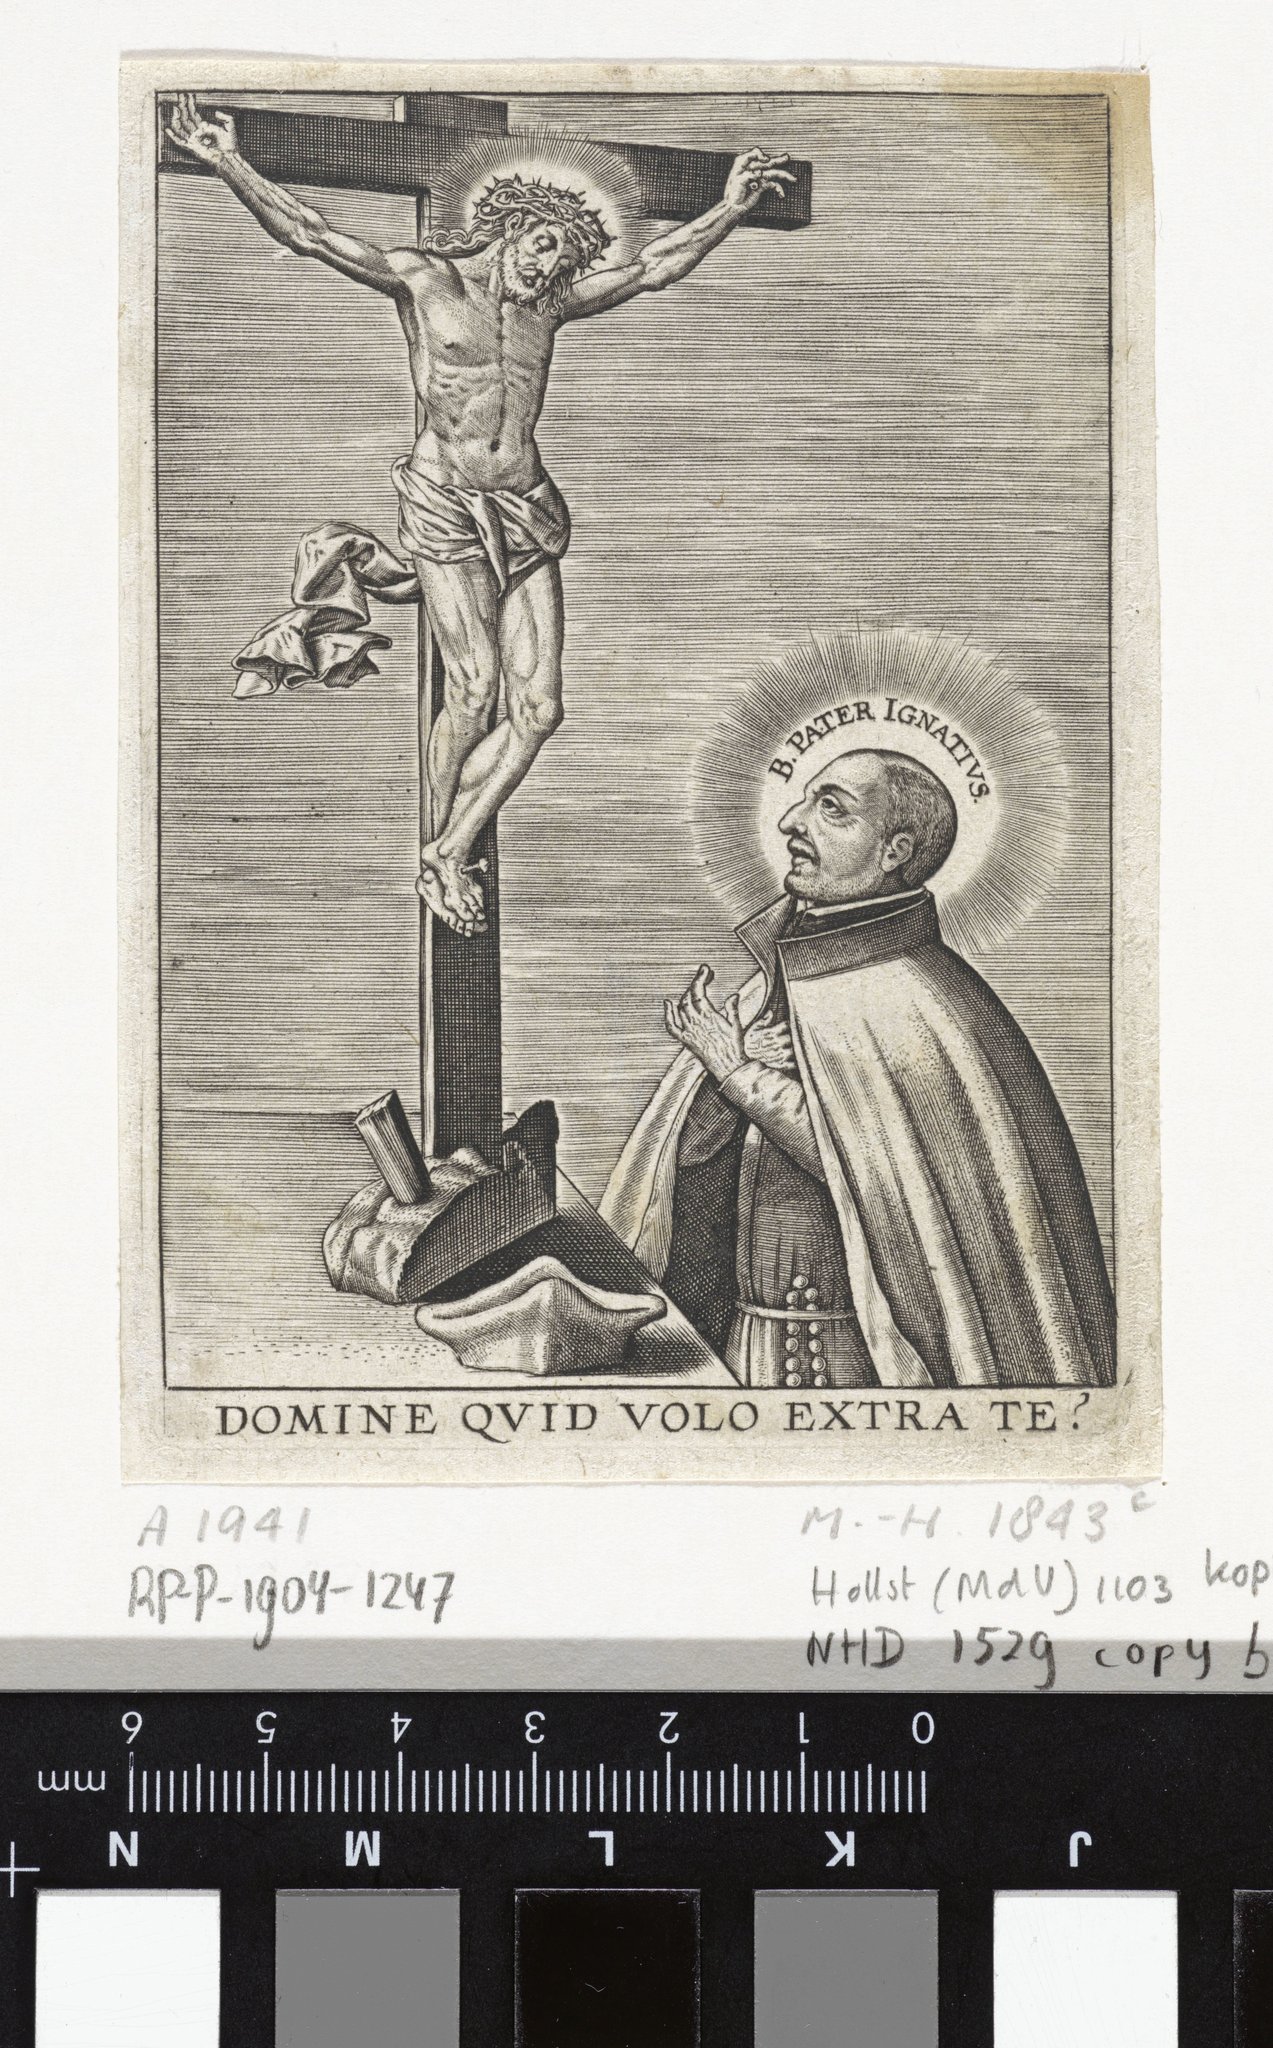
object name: print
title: Ignatius van Loyola in aanbidding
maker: Anonymous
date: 1563-1669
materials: paper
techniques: engraving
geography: antwerp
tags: clergyman, crucifix ~ personal devotion, the founder of the jesuit order, ignatius of loyola; possible attributes: book (with 'ad majorem dei gloriam'), demon, dragon under feet, flames, flaming heart, globe, ihs monogram, skull (with crown), tears in eyes, torch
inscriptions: collector's mark: Lugt 2228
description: De heilige Ignatius van Loyola in aanbidding voor een levensgroot crucifix. In de marge een onderschrift in het Latijn.